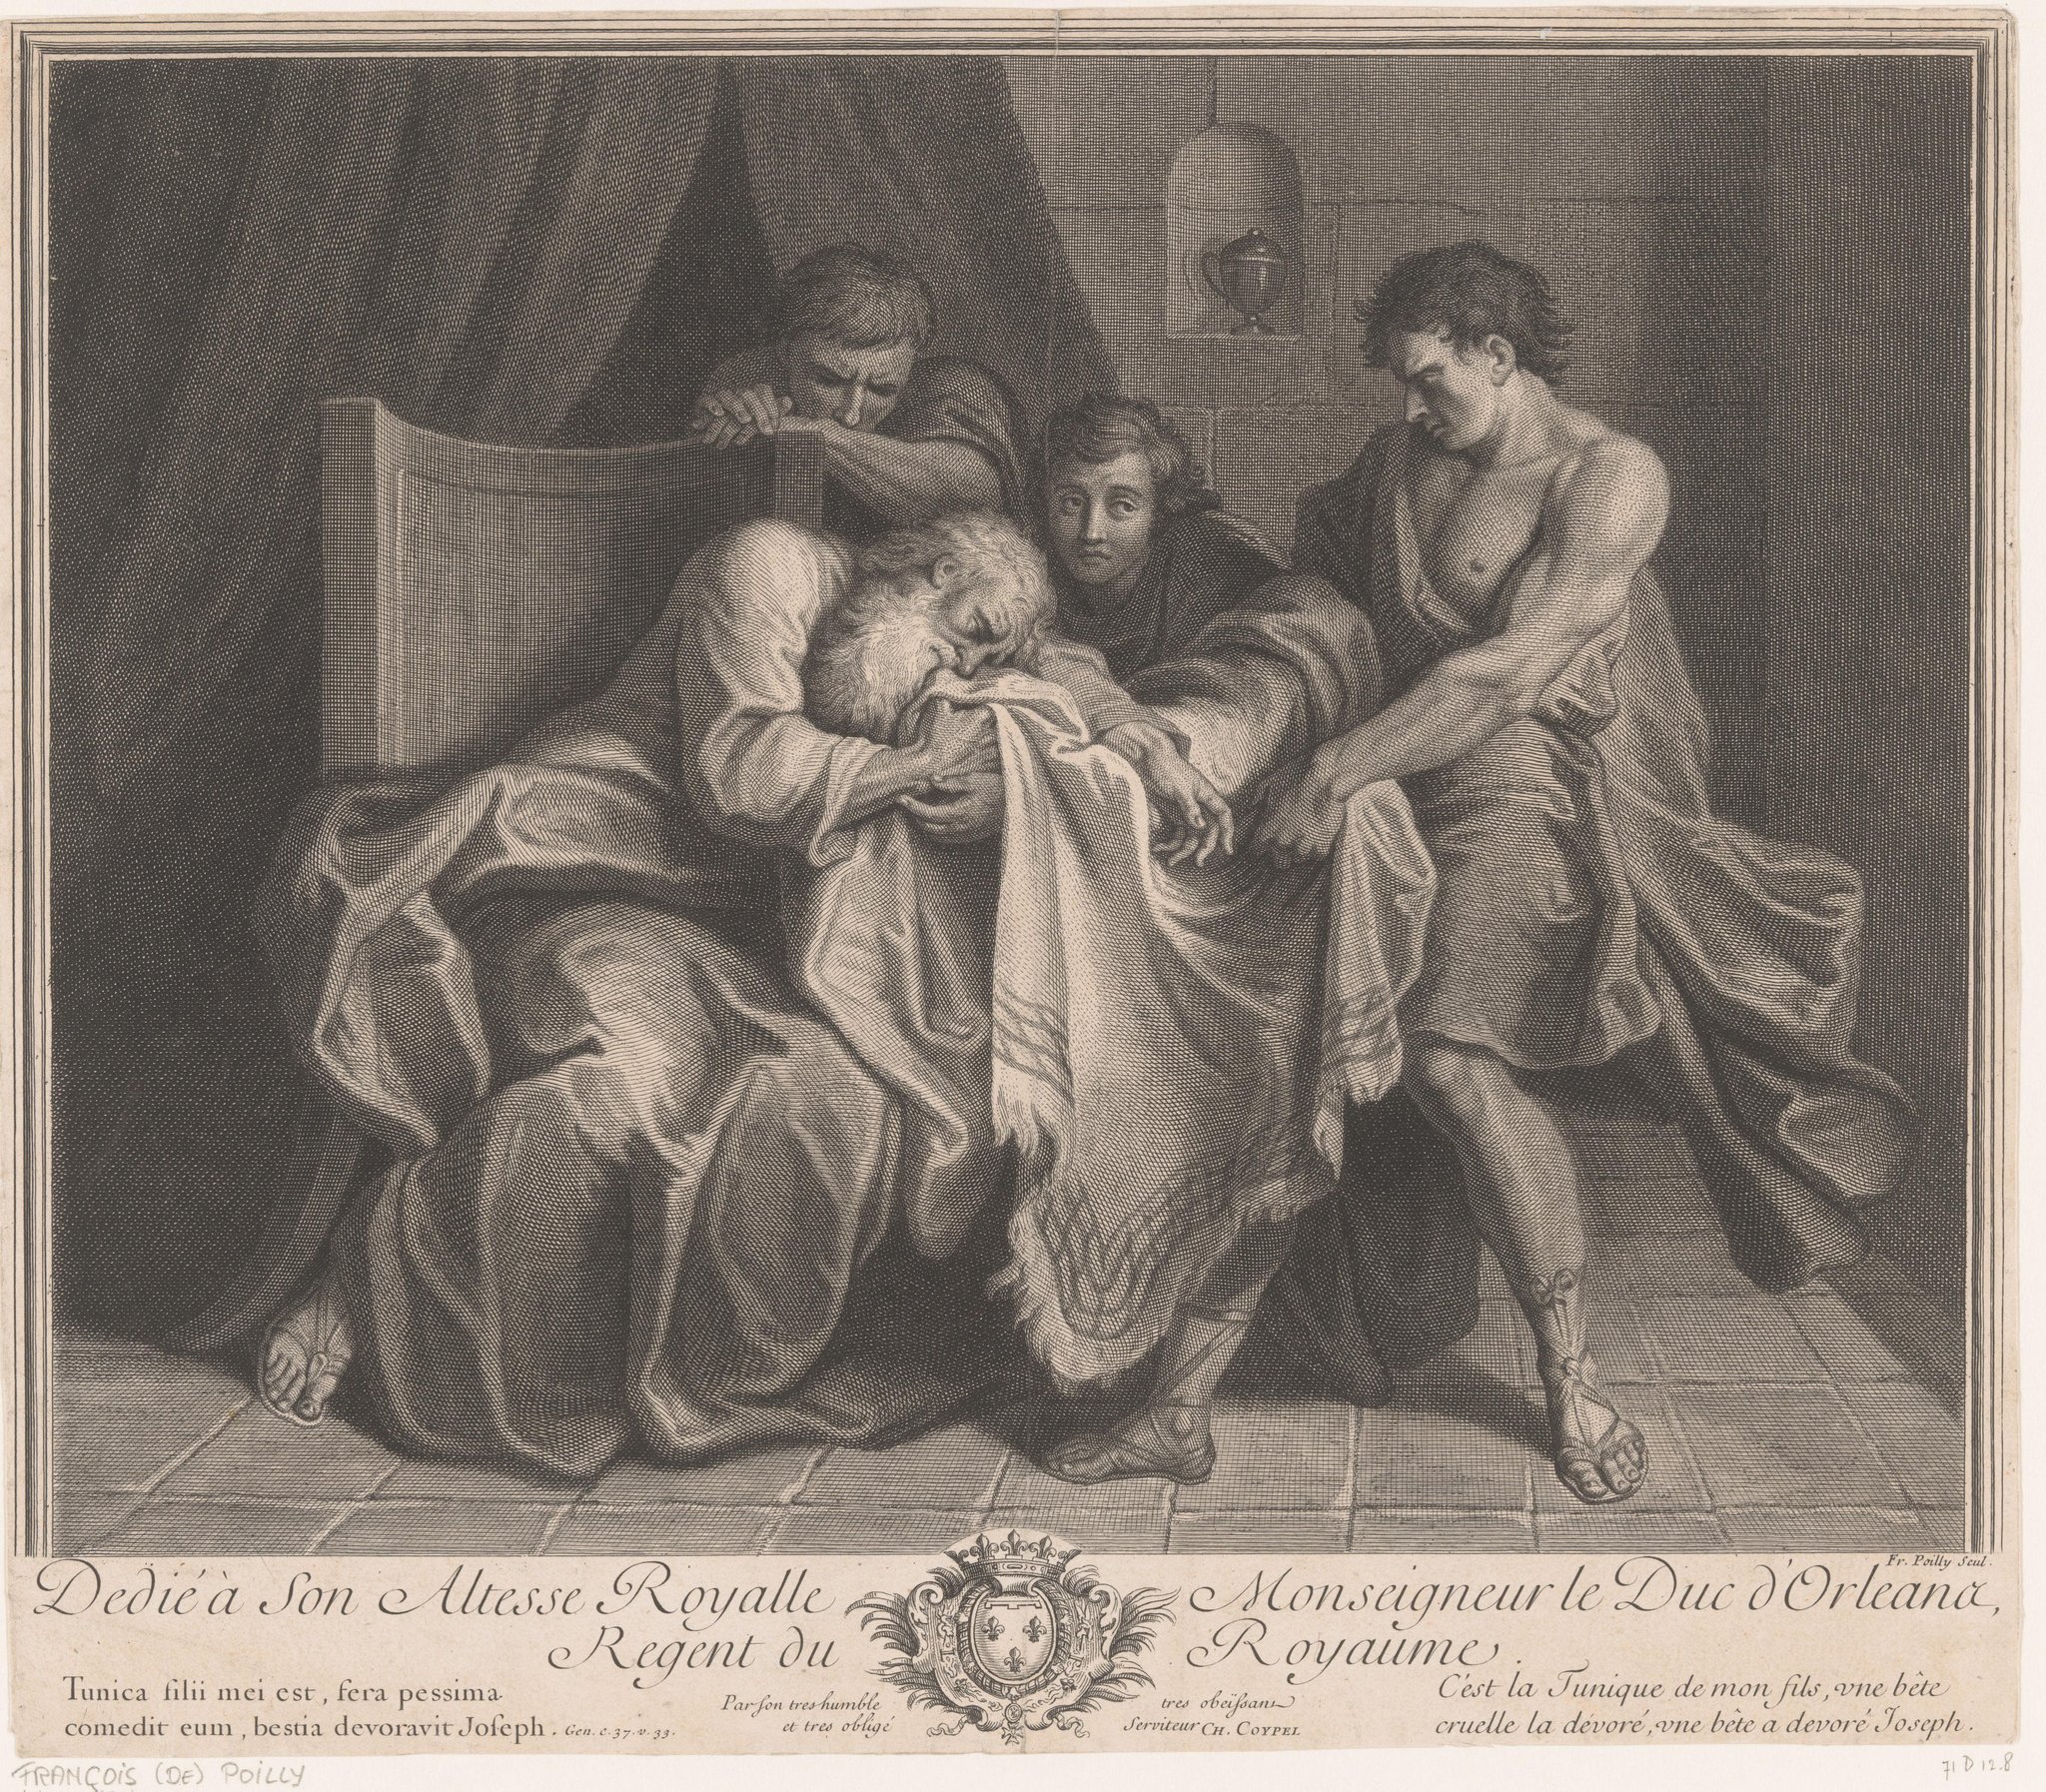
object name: print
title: Jakob krijgt het bebloede kleed van Jozef te zien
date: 1671-1693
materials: paper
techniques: engraving, etching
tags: joseph's blood-stained coat is brought and shown to jacob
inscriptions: collector's mark: Lugt 2228